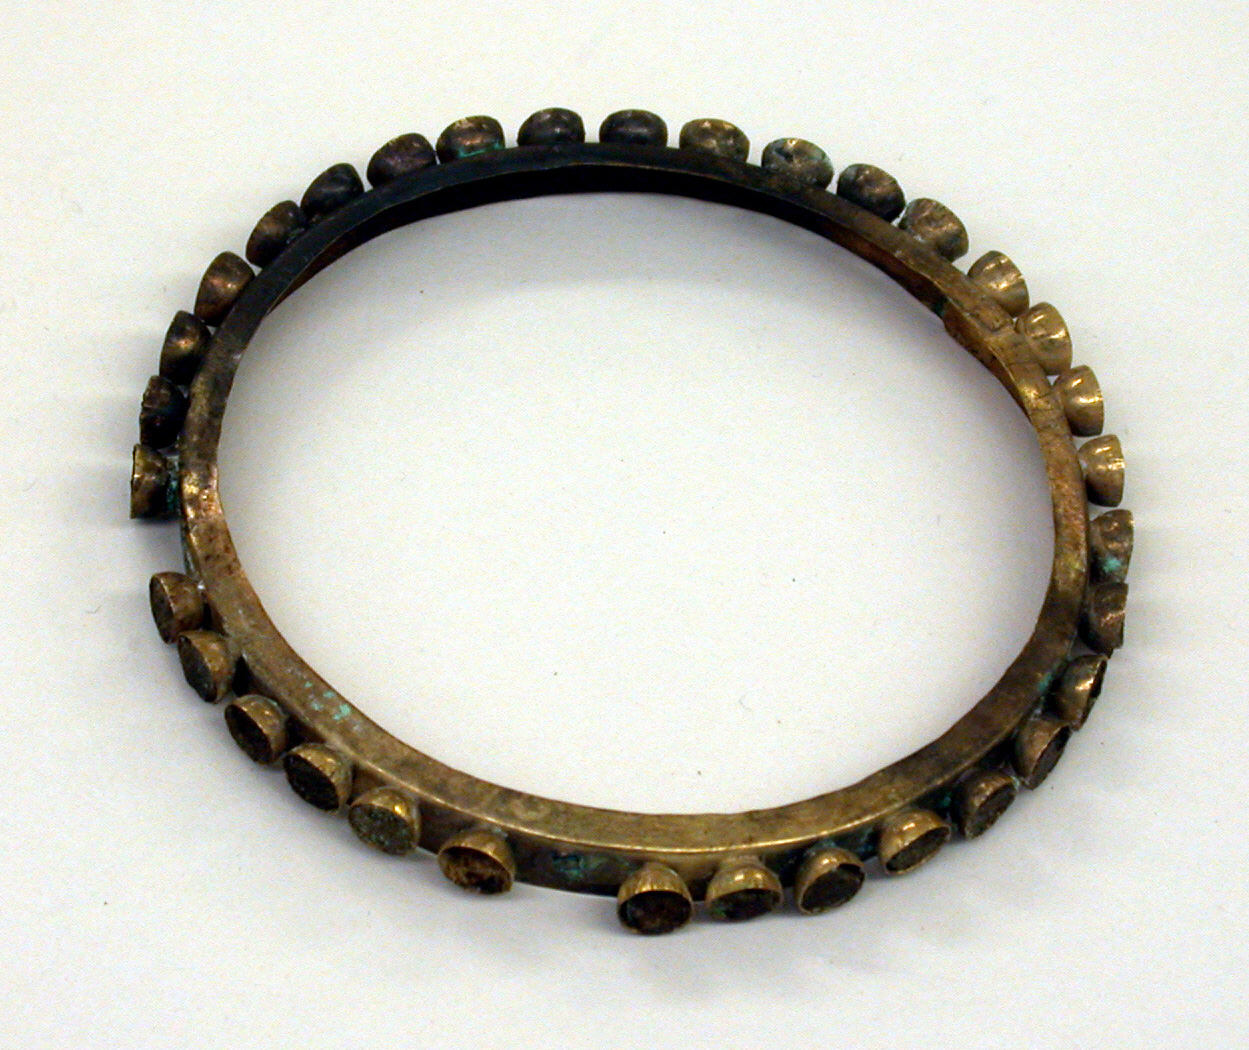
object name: earflare fragment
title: Earflare Rim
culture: moche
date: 501-700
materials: gold, stone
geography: peru